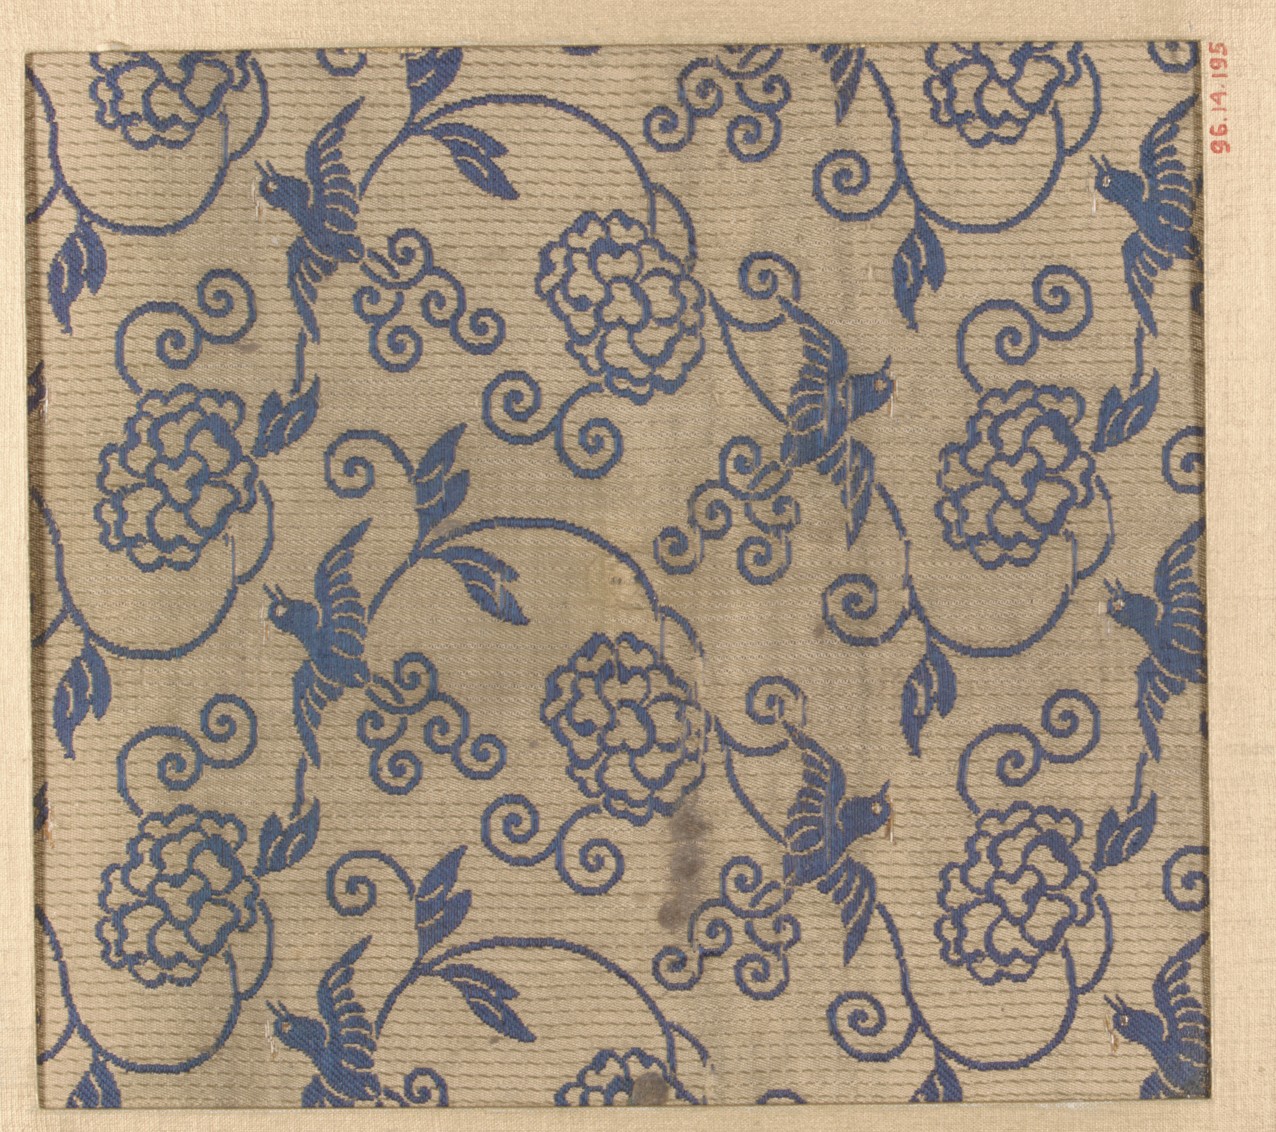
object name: piece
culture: japanese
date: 1701-1900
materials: silk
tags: flowers